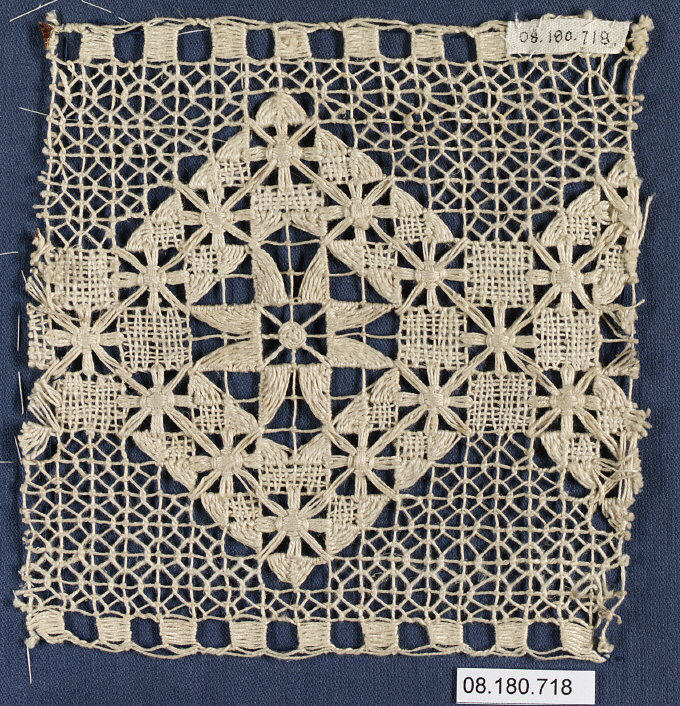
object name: insertion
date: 1801-1900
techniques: embroidery